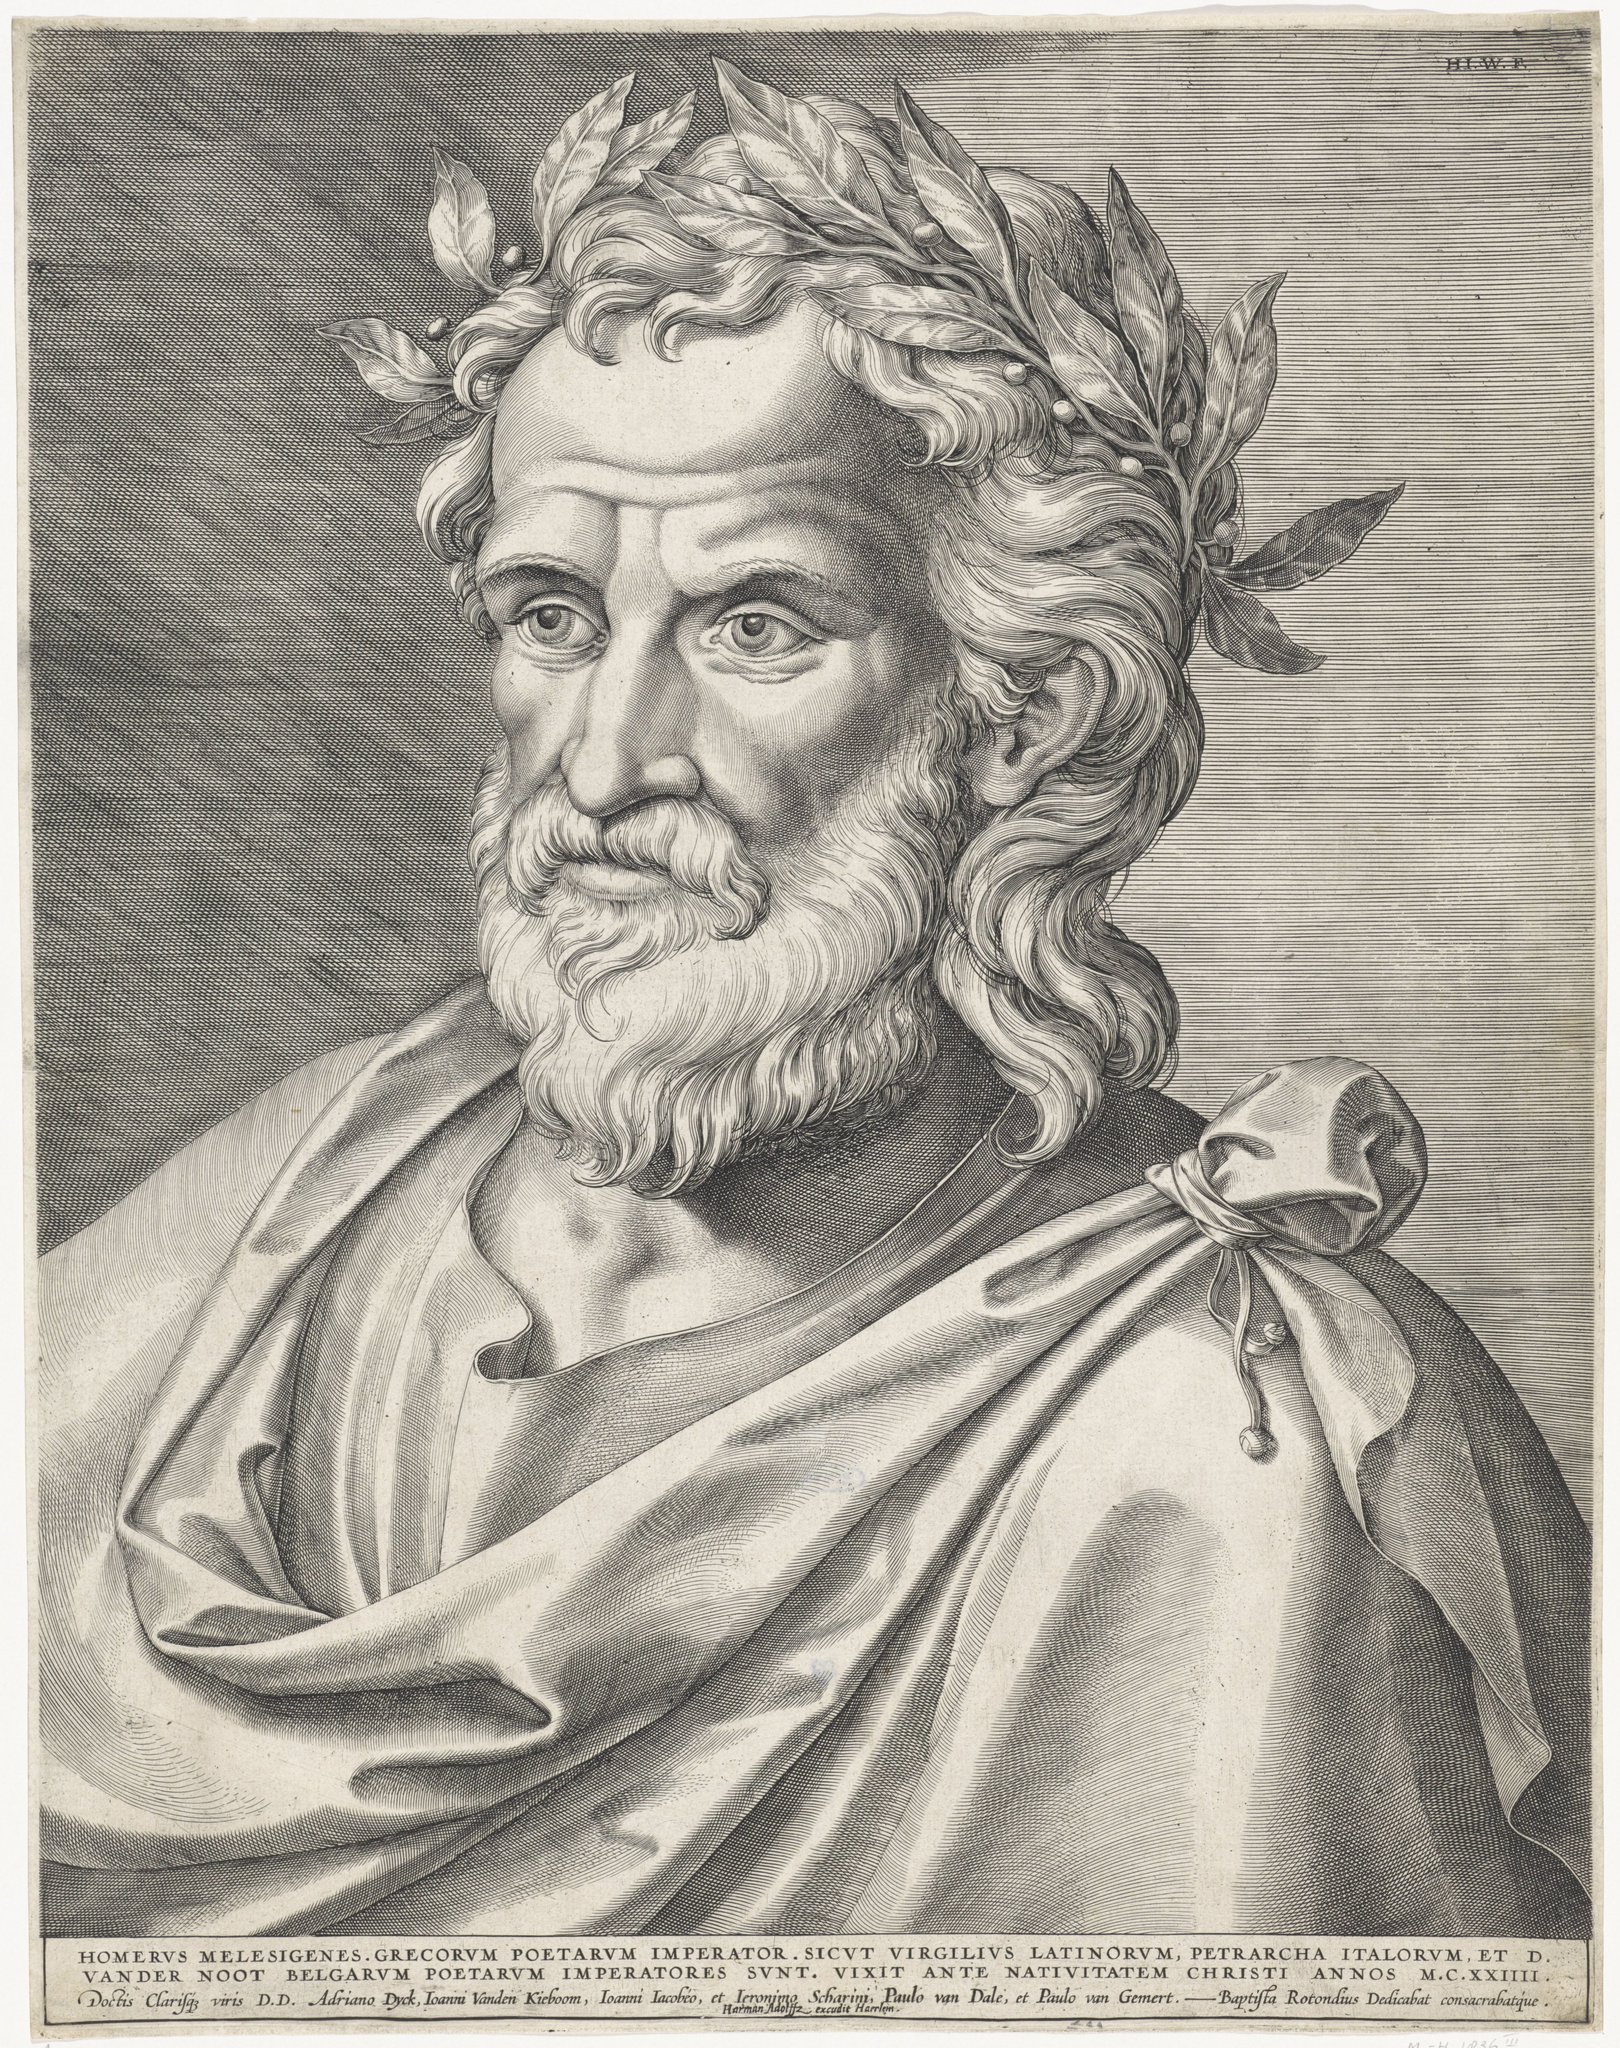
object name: print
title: Homerus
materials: paper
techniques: engraving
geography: antwerp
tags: portrait of homer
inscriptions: collector's mark: Lugt 2760, collector's mark: Lugt 2228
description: Portret van de dichter Homerus, met lauwerkrans op het hoofd. In de marge een tweeregelig onderschrift en een opdracht in het Latijn.